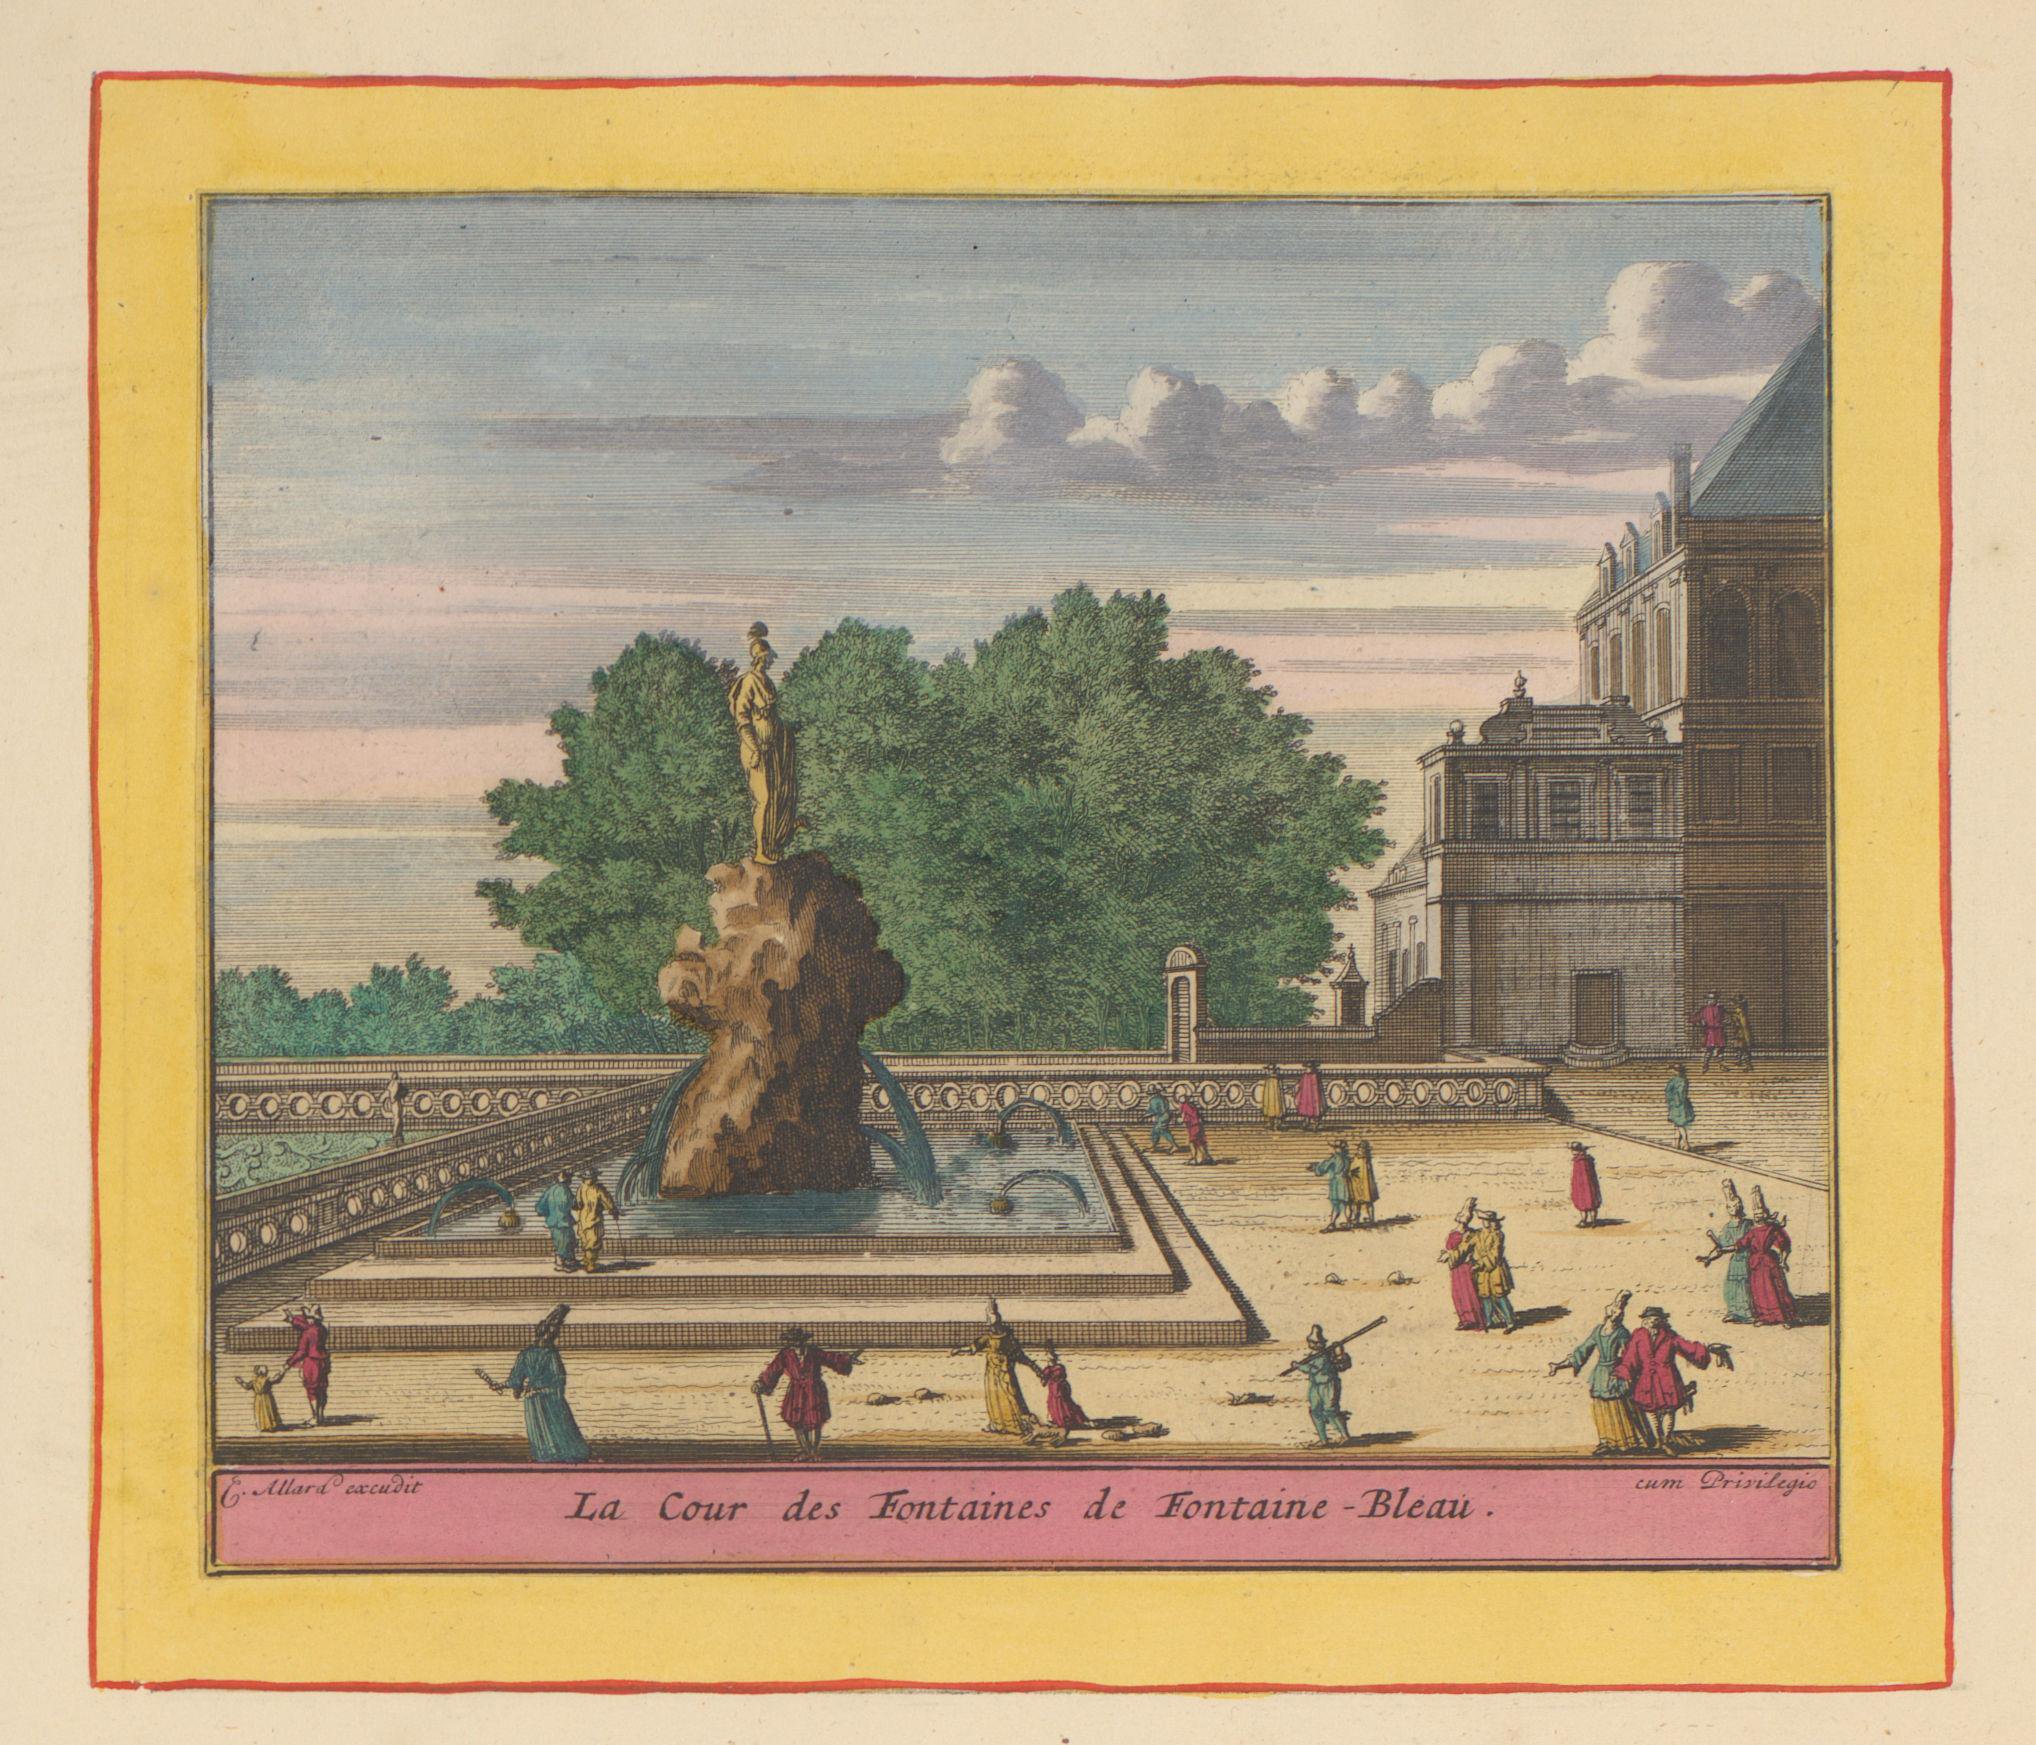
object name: album leaf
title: Gezichten op het paleis van Fontainebleau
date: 1684-1709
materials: paper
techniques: etching, hand coloring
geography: northern netherlands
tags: palace, french or architectonic garden; formal garden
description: De Cour de la Fontaine in de tuin van het paleis van Fontainebleau, met wandelende figuren bij een fontein. Prent maakt deel uit van een album.